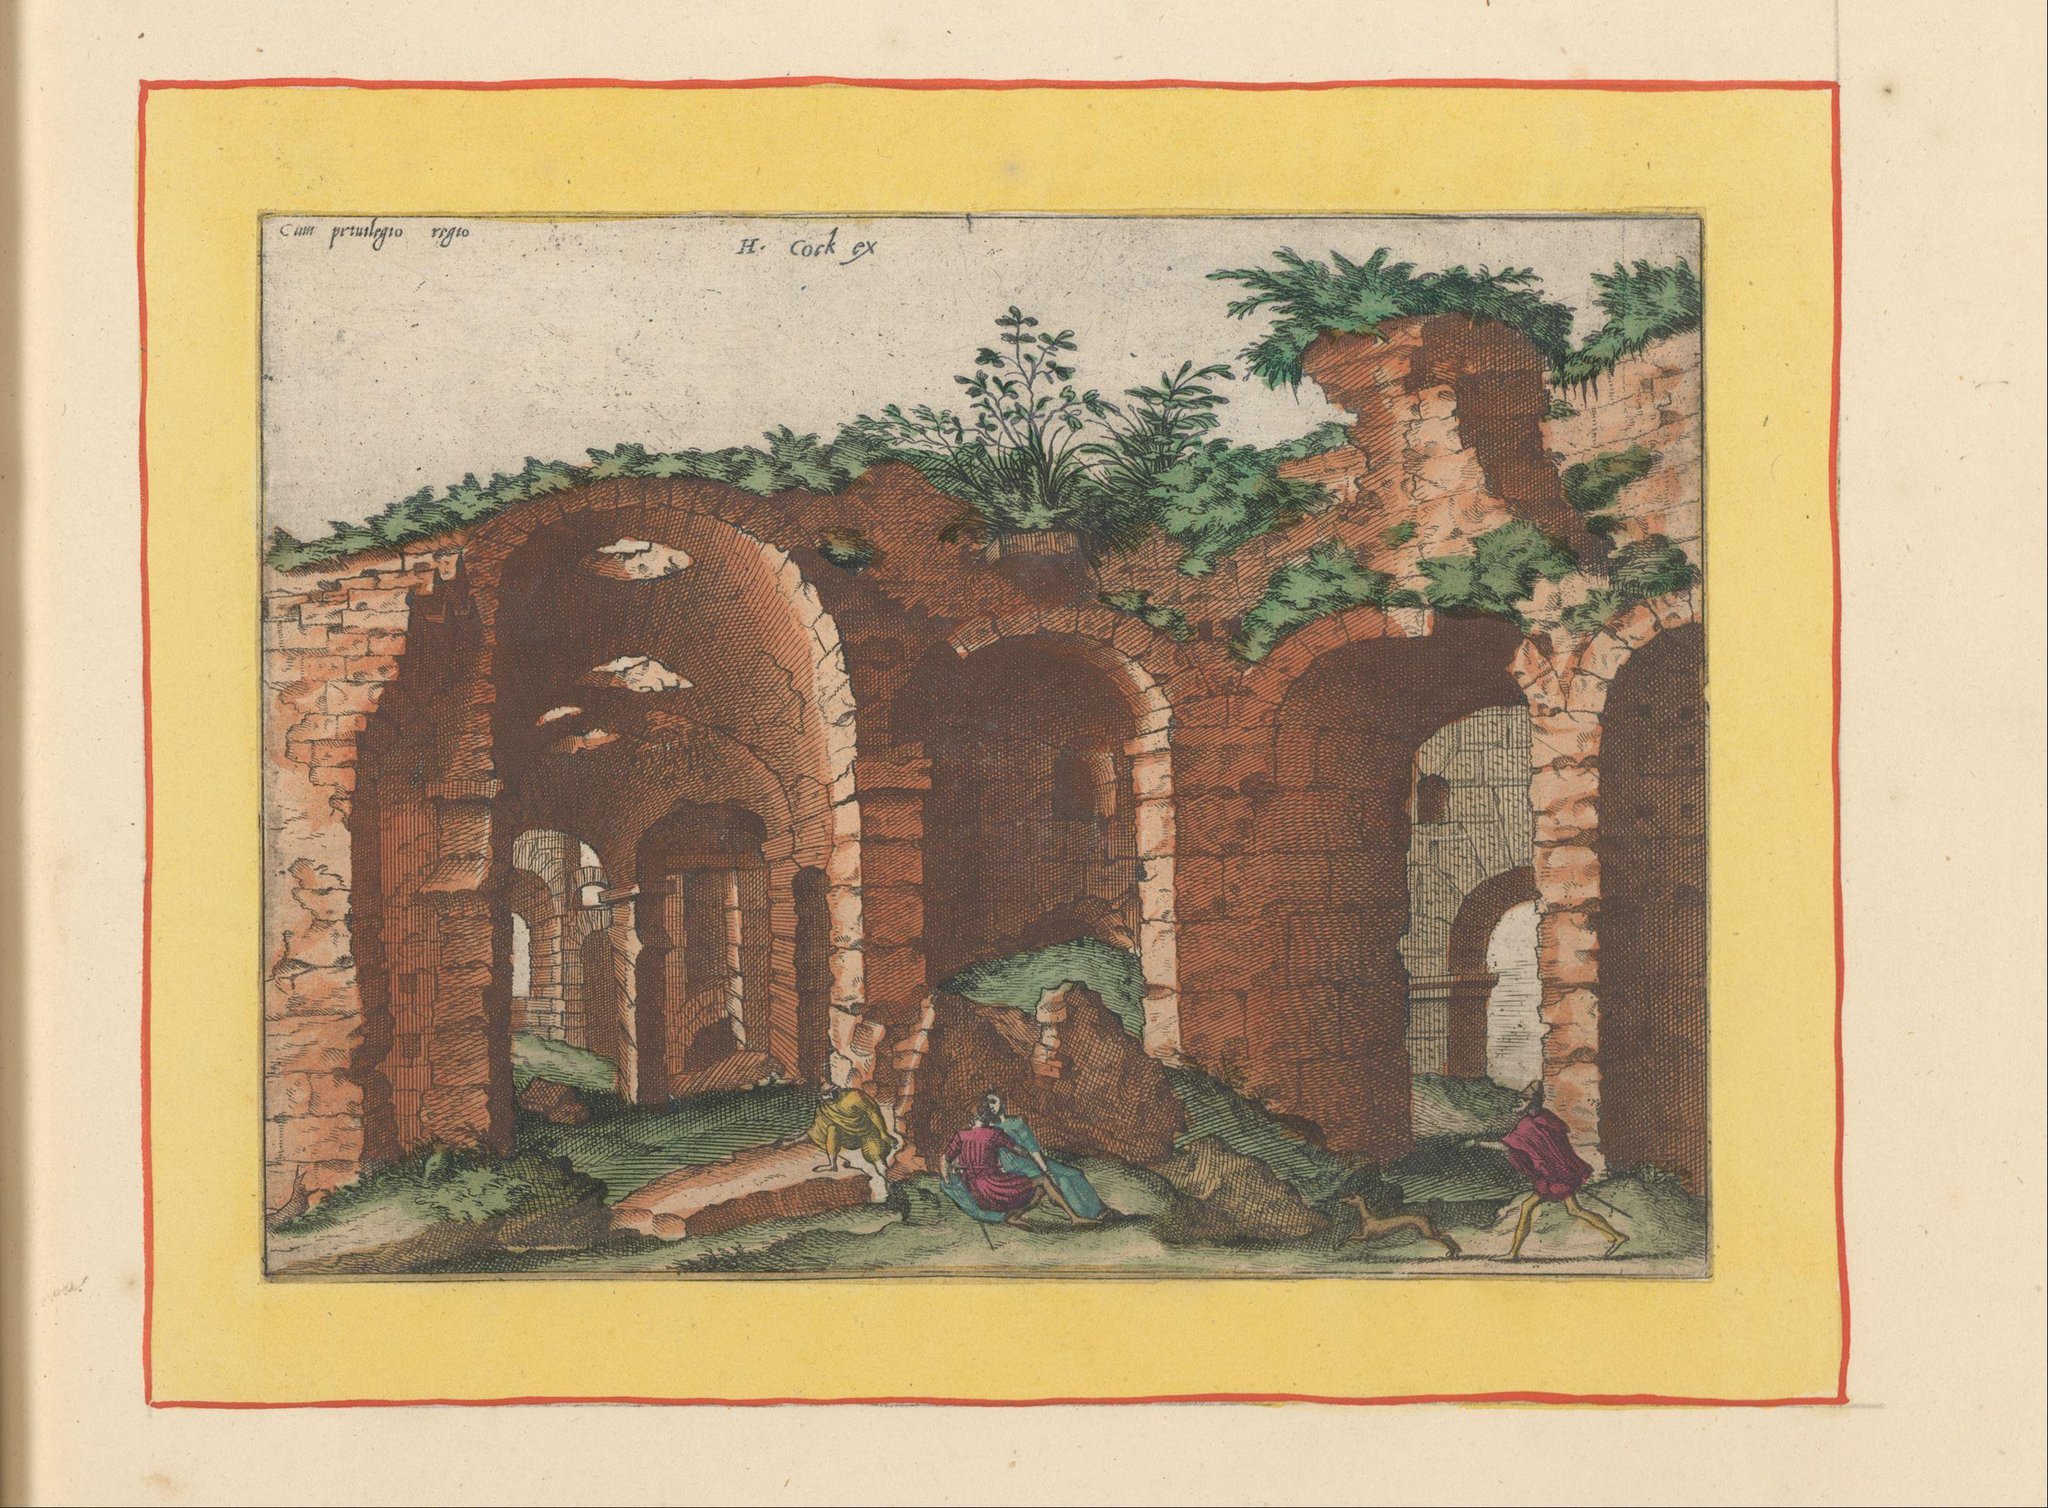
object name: album leaf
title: Ruïne met booggewelven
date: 1562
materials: paper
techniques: colour, etching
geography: antwerp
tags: column, pillar ~ architecture, ruin of a building ~ architecture, arch, archivolt ~ architecture, landscape with ruins, rome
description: Gezicht op een ruïne van een gebouw met booggewelven. Op de voorgrond ligt een minnend paar dat wordt begluurd door twee mannen met een hond. Prent maakt deel uit van een album.